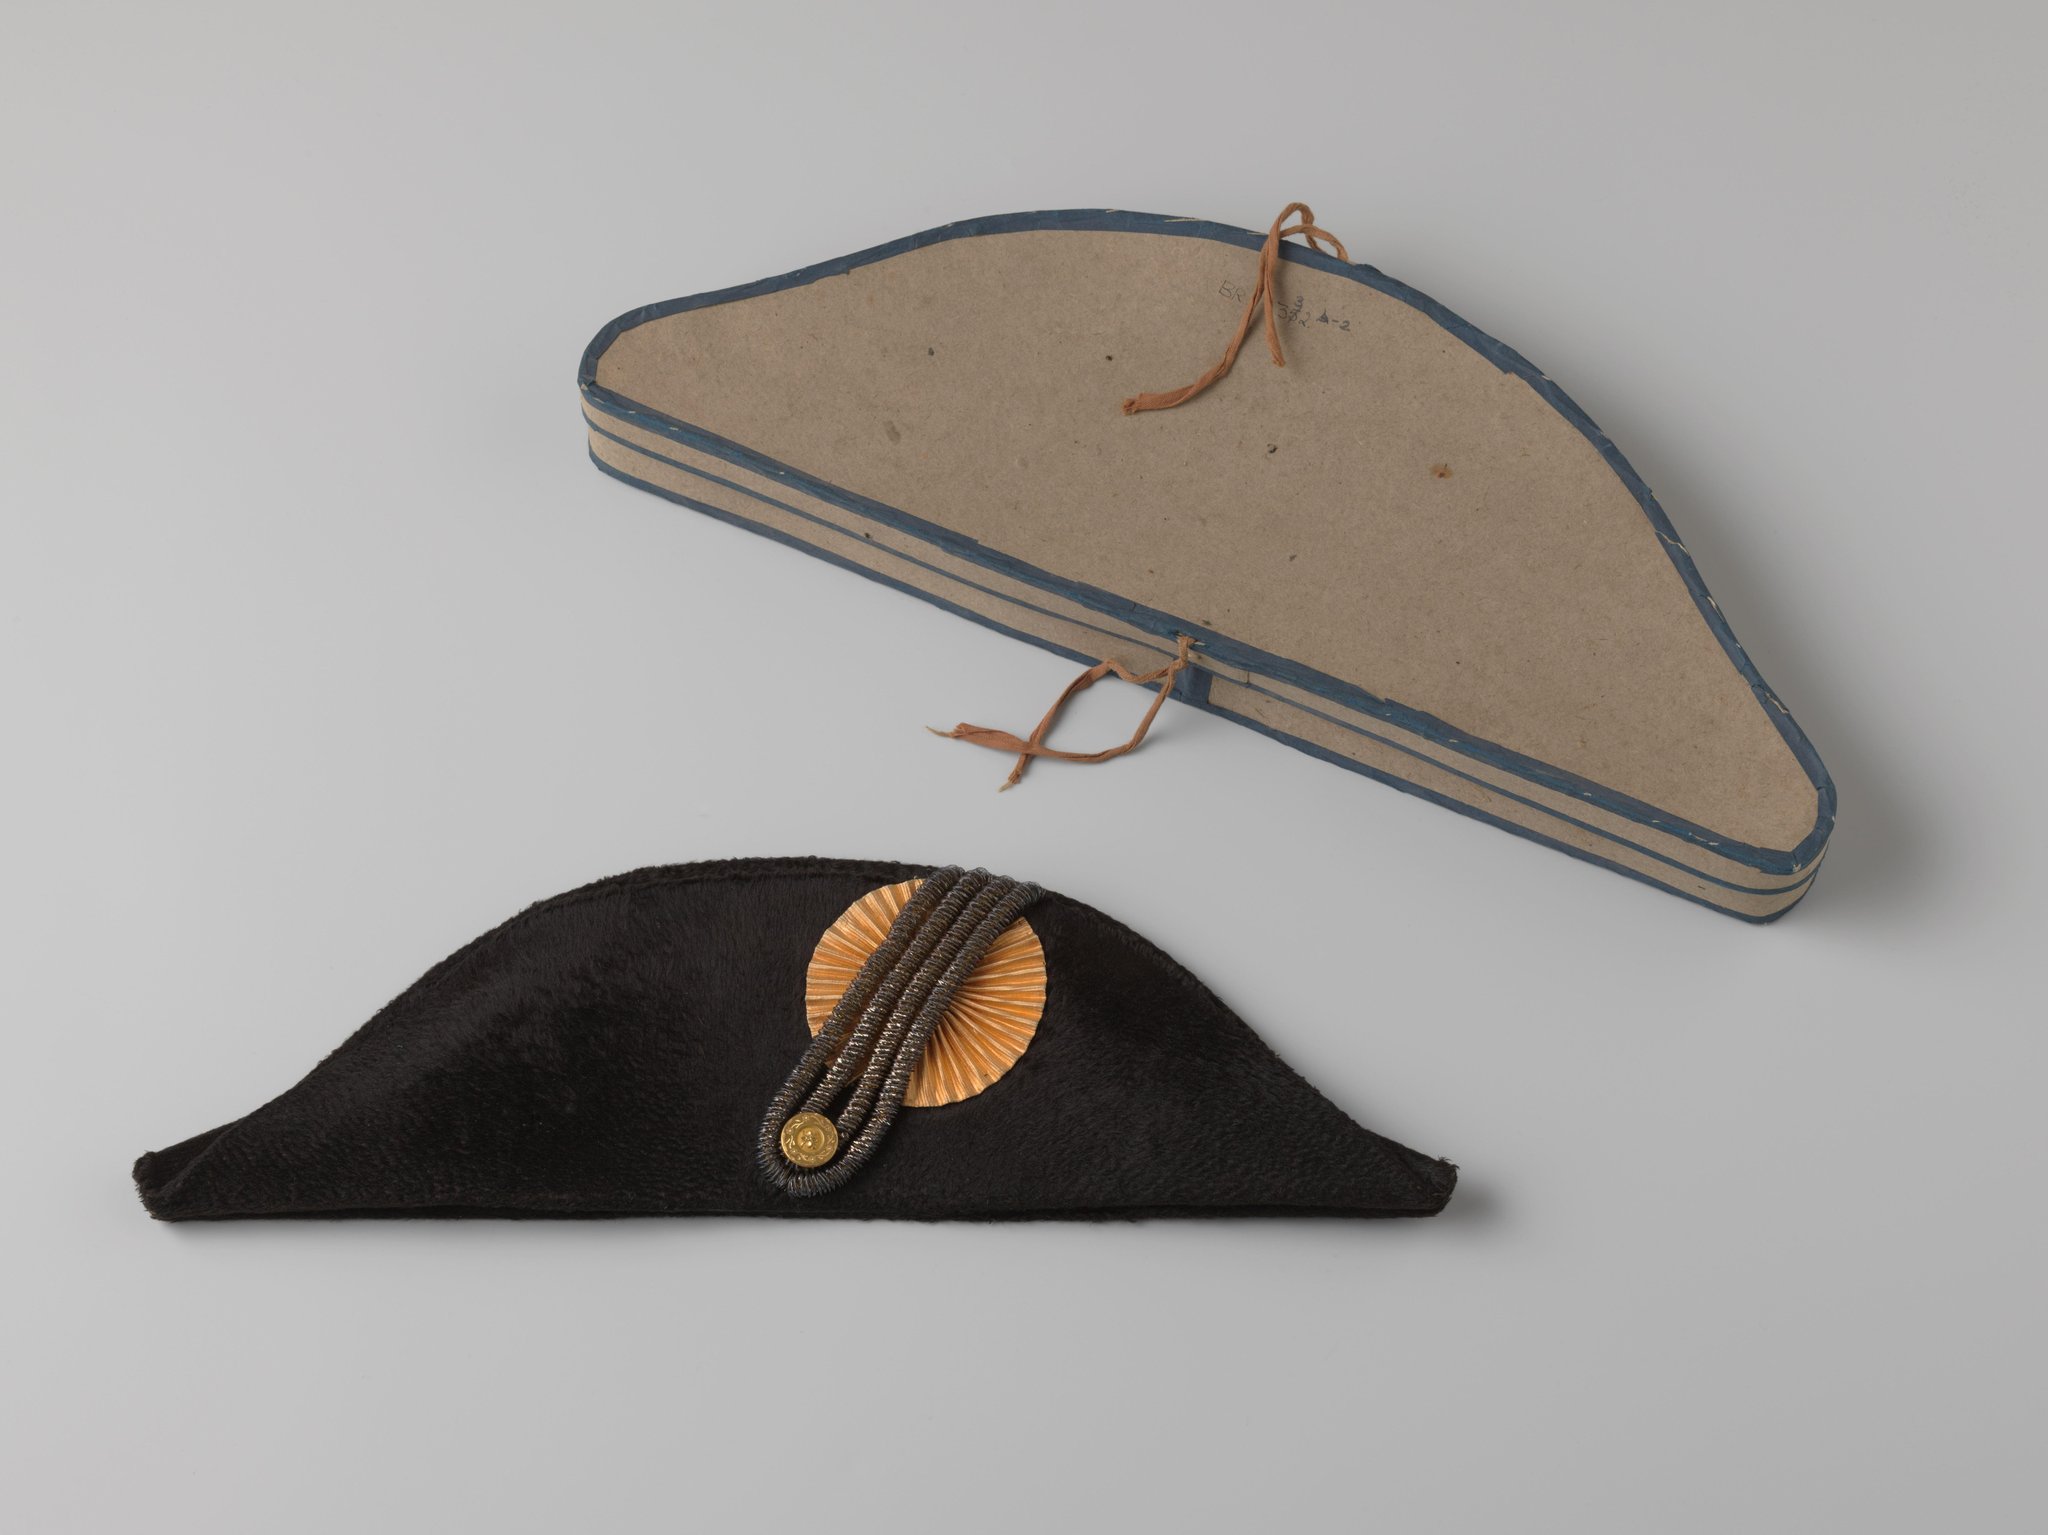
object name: clothing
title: Herenhoedendoos van grijs karton, afgezet met blauwe biezen van papier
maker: Anonymous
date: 1800-1900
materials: cardboard, paper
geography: western europe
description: Hoedendoos van grijs karton, afgezet met blauwe biezen van papier.